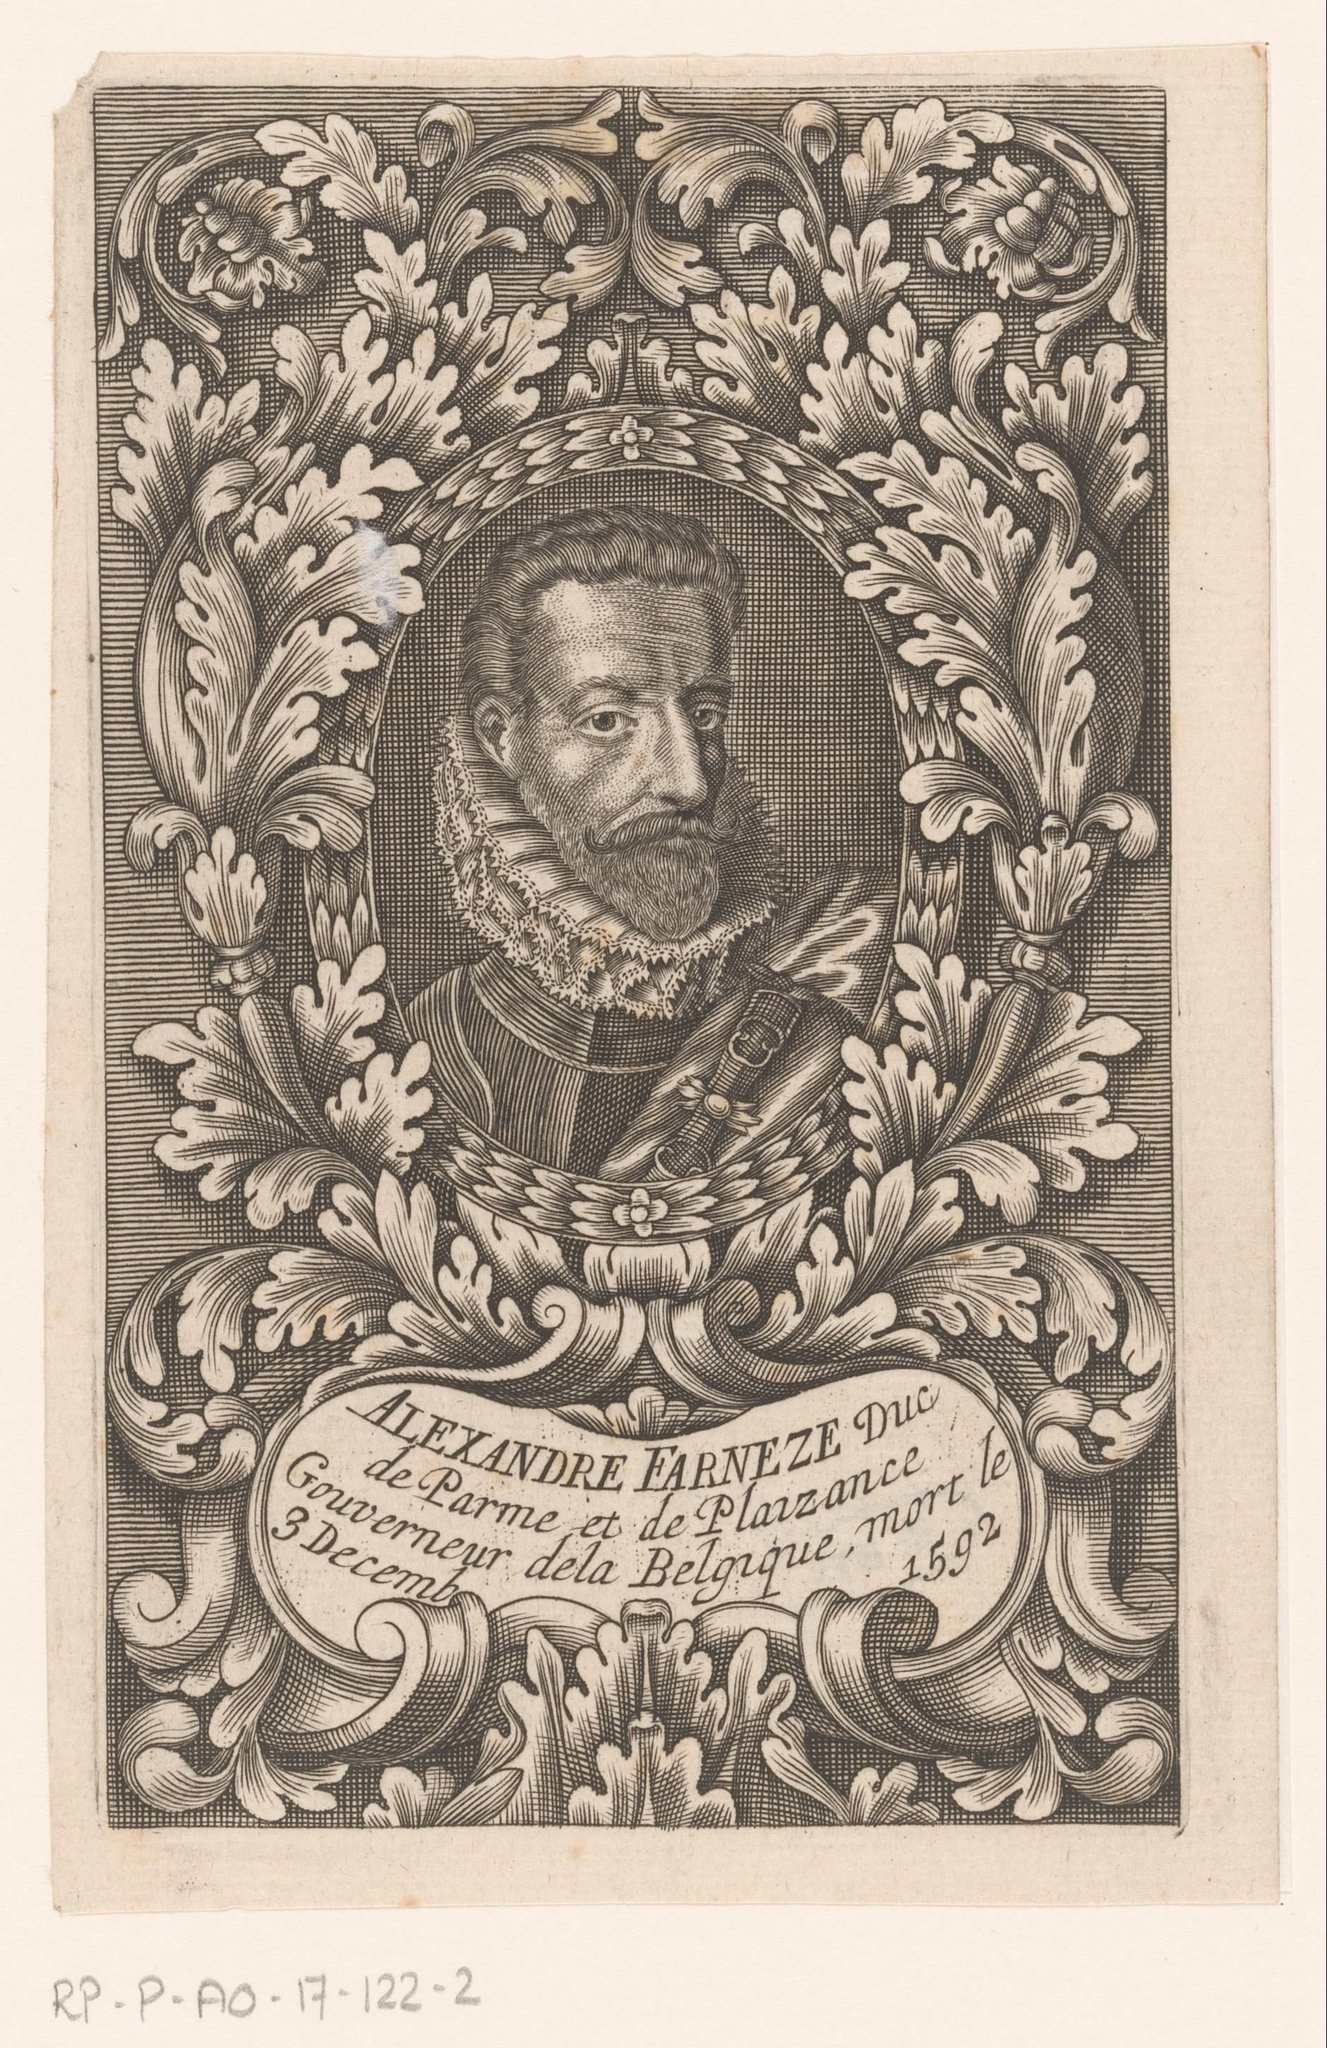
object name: print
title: Portret van Alexander Farnese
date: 1692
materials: paper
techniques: engraving, etching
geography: amsterdam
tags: rome, alessandro farnese (landvoogd van de nederlanden en hertog van parma en piacenza)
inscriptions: collector's mark: Lugt 2228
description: Prent ook gebruikt in: Bruslé de Montpleinchamp, Jean Chrysostome. L'histoire d'Alexandre Farneze, duc de Parme et de Plaizance, gouverneur de la Belgique. Amsterdam: Antoine Michiels, 1692.